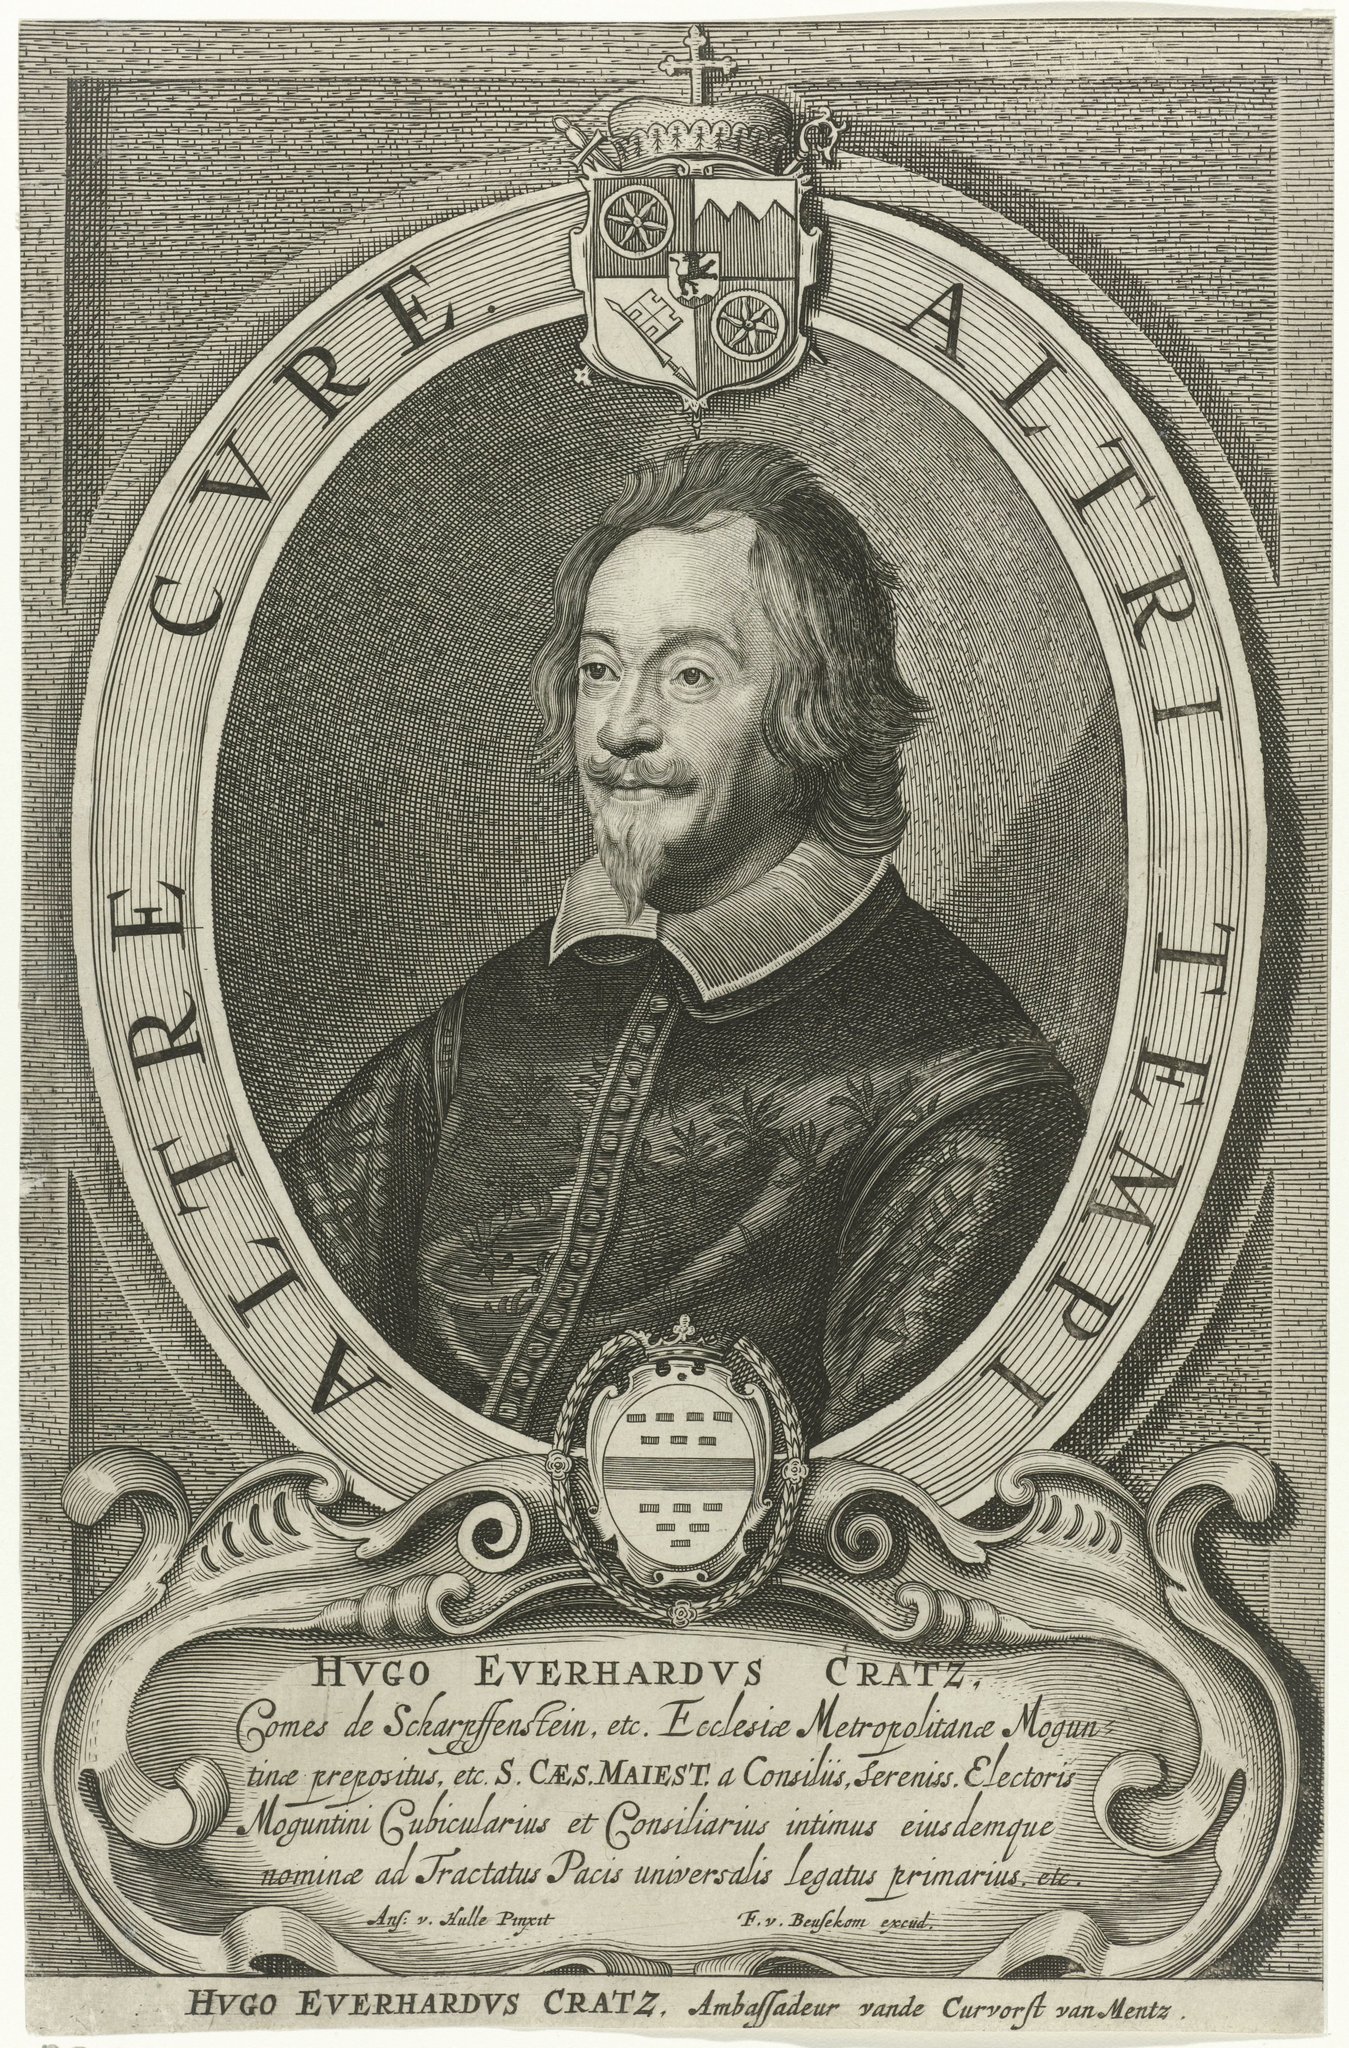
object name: print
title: Portret van Hugo Everhard Cratz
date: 1616-1744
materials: paper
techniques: engraving, etching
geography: antwerp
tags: regensburg, bisschop, diplomaat, hugo everhard cratz (graaf van scharfenstein)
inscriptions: collector's mark: Lugt 2228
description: Busteportret van Hugo Everhard Cratz, graaf van Scharfenstein. Het portret is gevat in een ovale omlijsting met het wapenschild van de geportretteerde en een randschrift in het Latijn. In de cartouche een vijfregelig onderschrift in het Latijn. In de marge de naam en functie van de geportretteerde in het Nederlands. Kopie naar de gelijknamige prent van Pieter de Jode II uit een serie portretten naar schilderijen van Anselmus van Hulle van alle gedelegeerden bij de vredesonderhandelingen te Münster en Osnabrück.